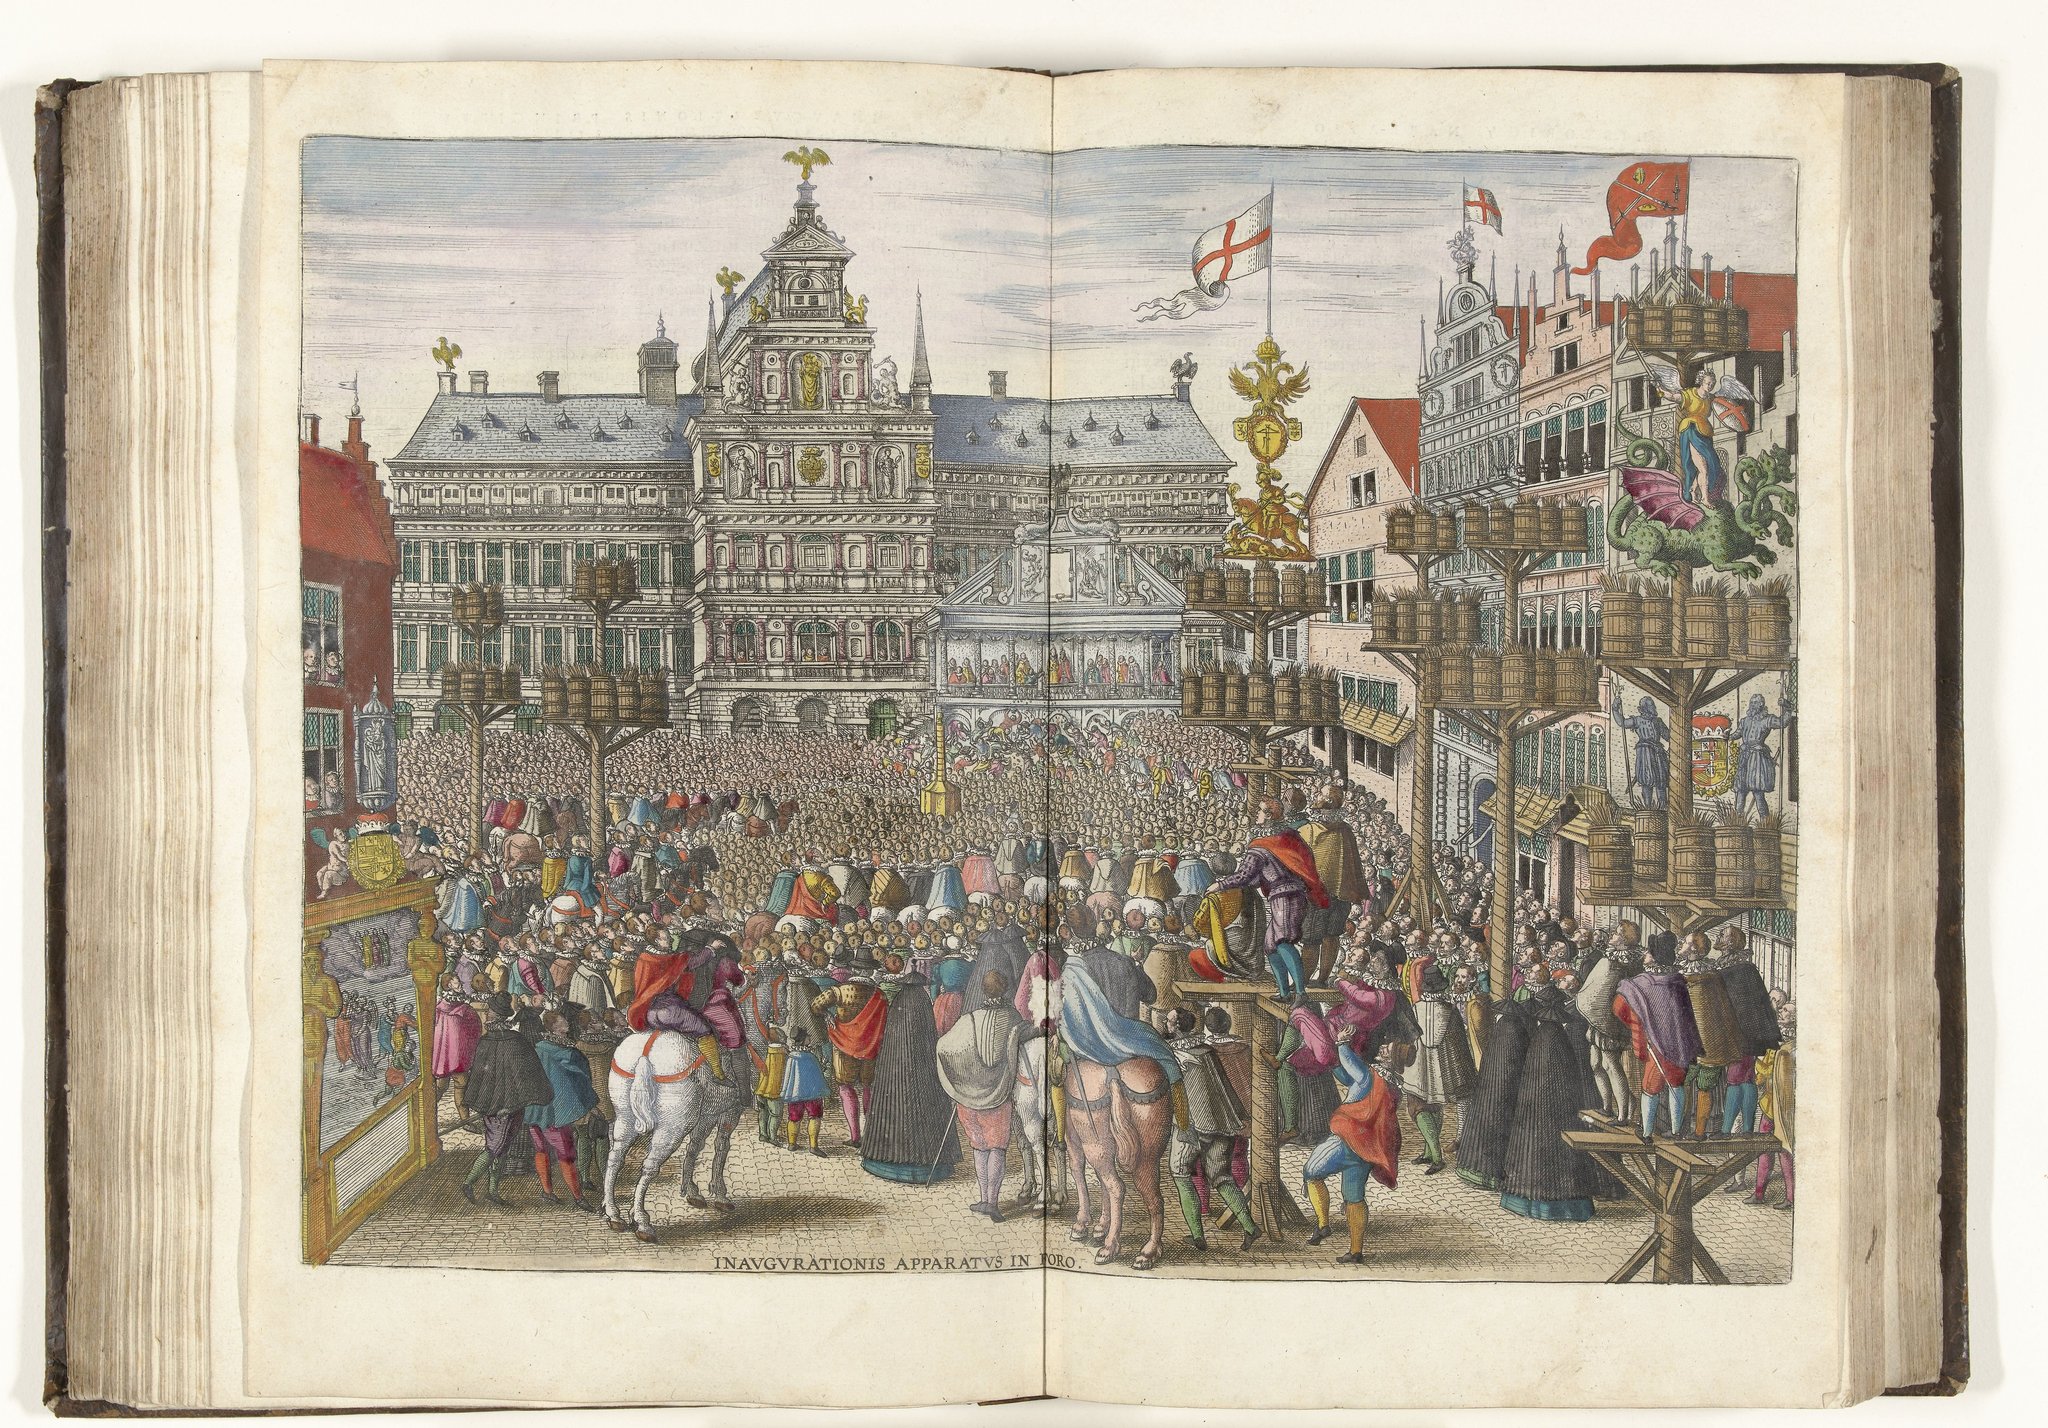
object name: print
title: Inhuldiging op de Grote Markt, 1599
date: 1599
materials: paper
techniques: etching, hand coloring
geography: southern netherlands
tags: infante van spanje isabella clara eugenia, brussels, albrecht aartshertog van oostenrijk, new ruler taking the oath, scattering of money (~ triumphal entry, etc.), triumphal entry and public reception, pageant, 'entrée solennelle', 'joyeuse entrée', antwerp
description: Inhuldiging op een podium voor het stadhuis op de Grote Markt, december 1599. Een grote menigte verzameld op het plein, op de voorgrond palen met pektonnen versierd met afbeeldingen van de heilige Joris die de draak verslaat. Vanaf het podium wordt met munten en penningen gestrooid. Tijdens de intocht te Antwerpen. Onderdeel van: Historica narratio profectionis et inaugurationis serenissimorum Belgii principum Alberti et Isabellae Austriae archiducum, de beschrijving van de intochten van het paar te Brussel, Antwerpen, Gent en Valenciennes, 1599.